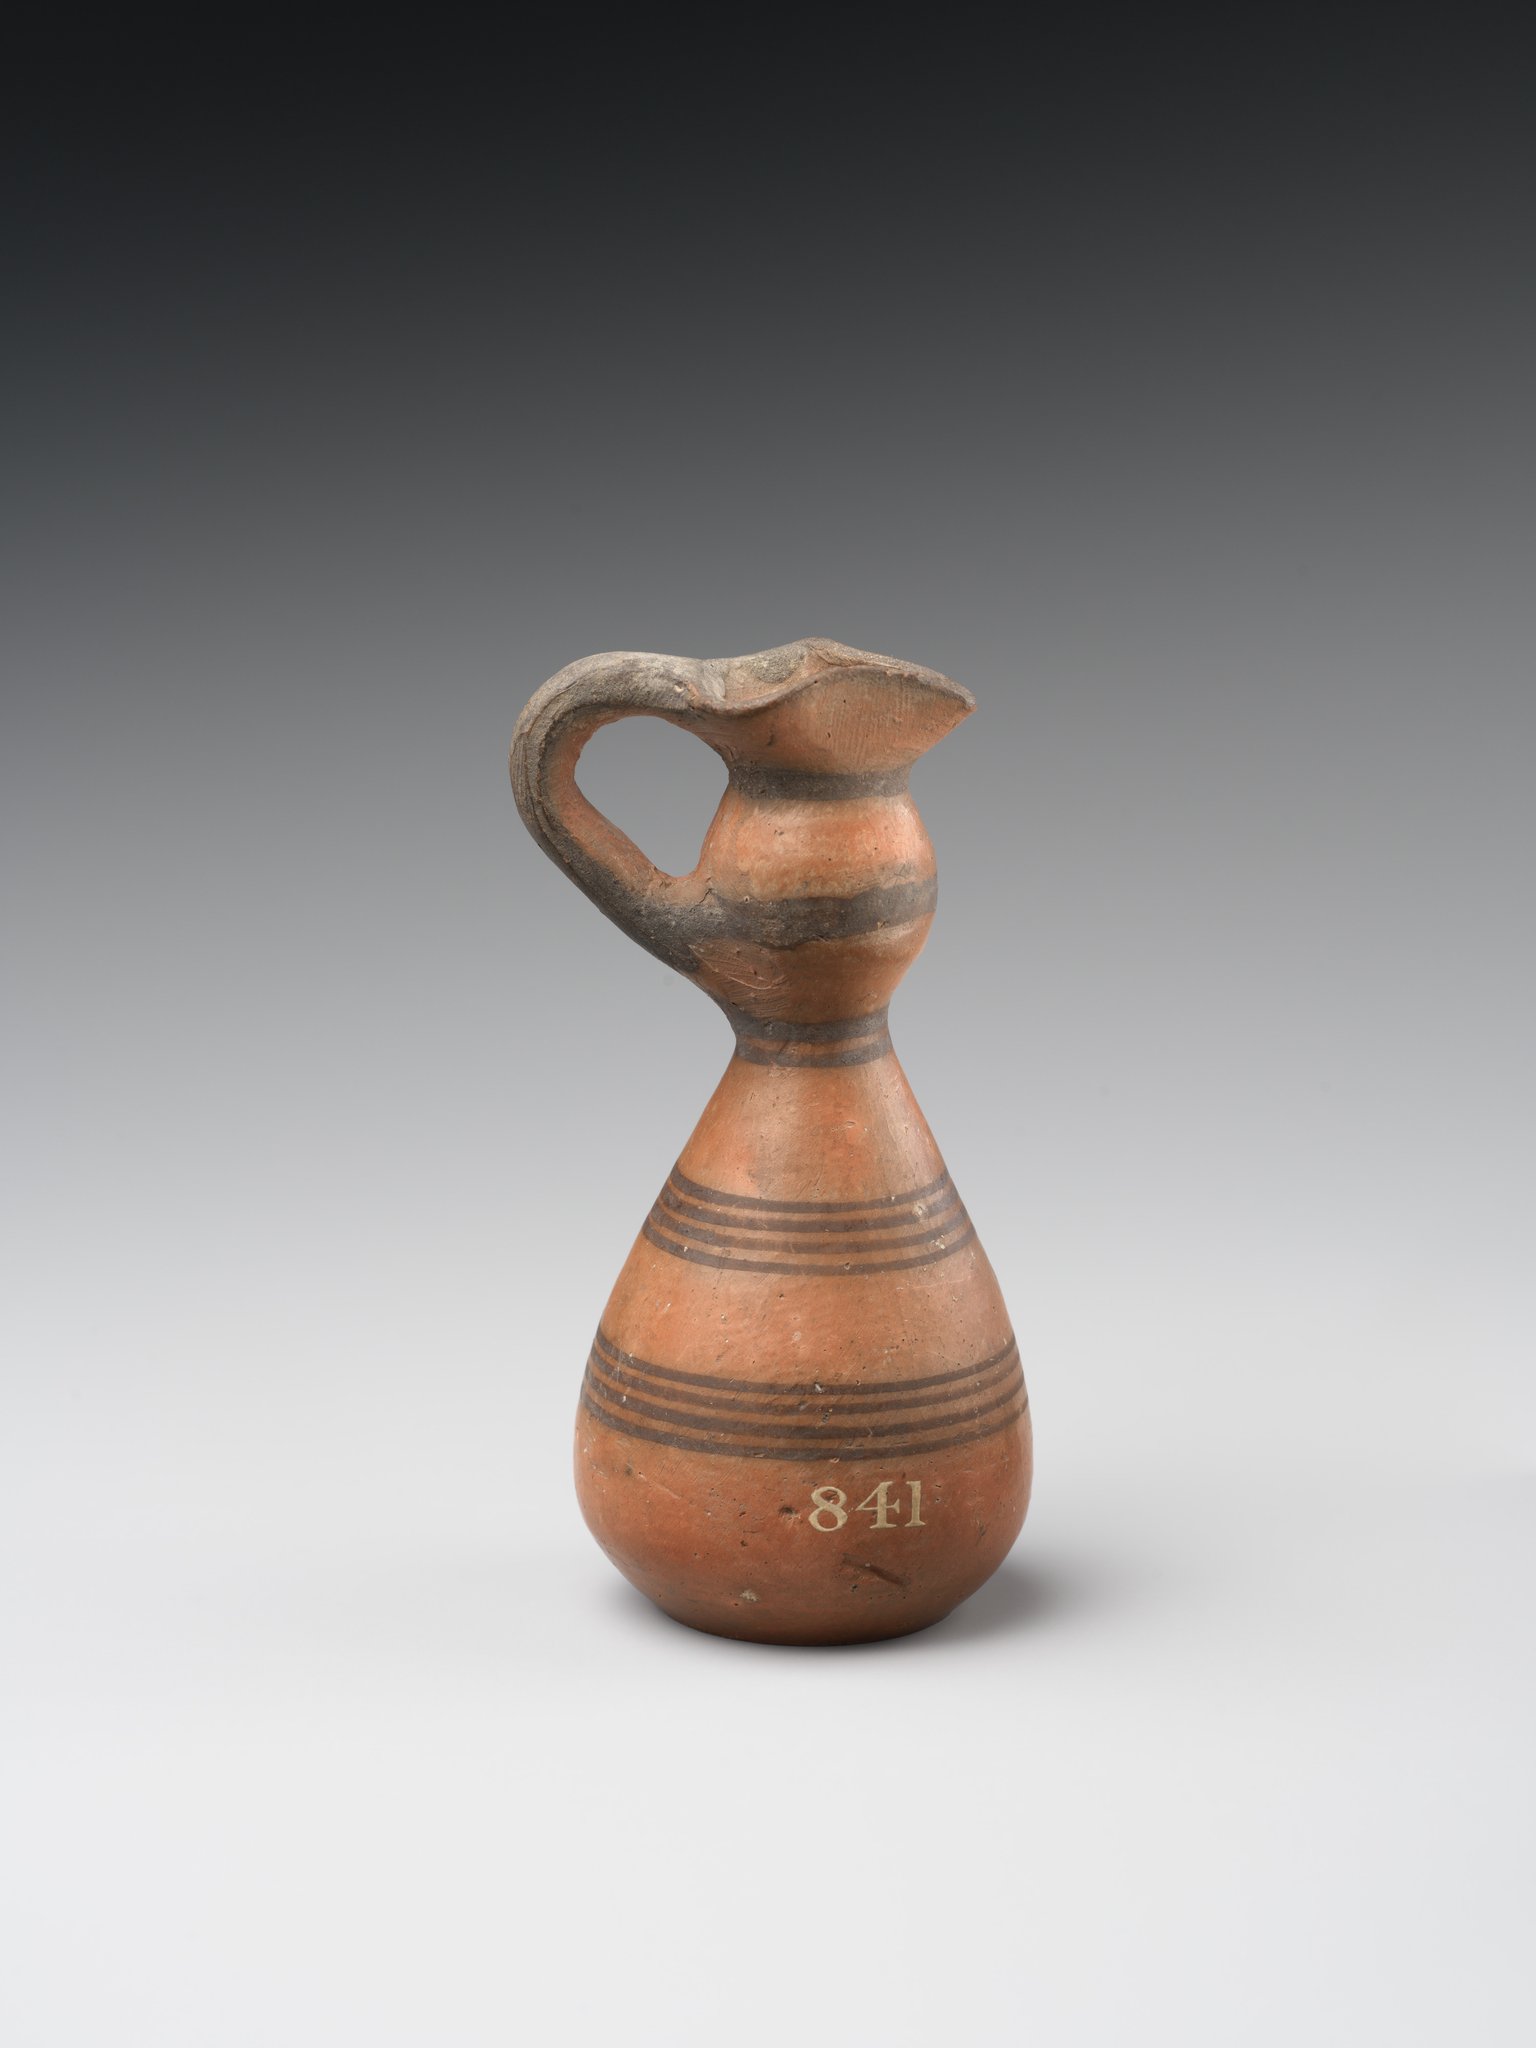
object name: juglet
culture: cypriot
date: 750-600 BCE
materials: terracotta